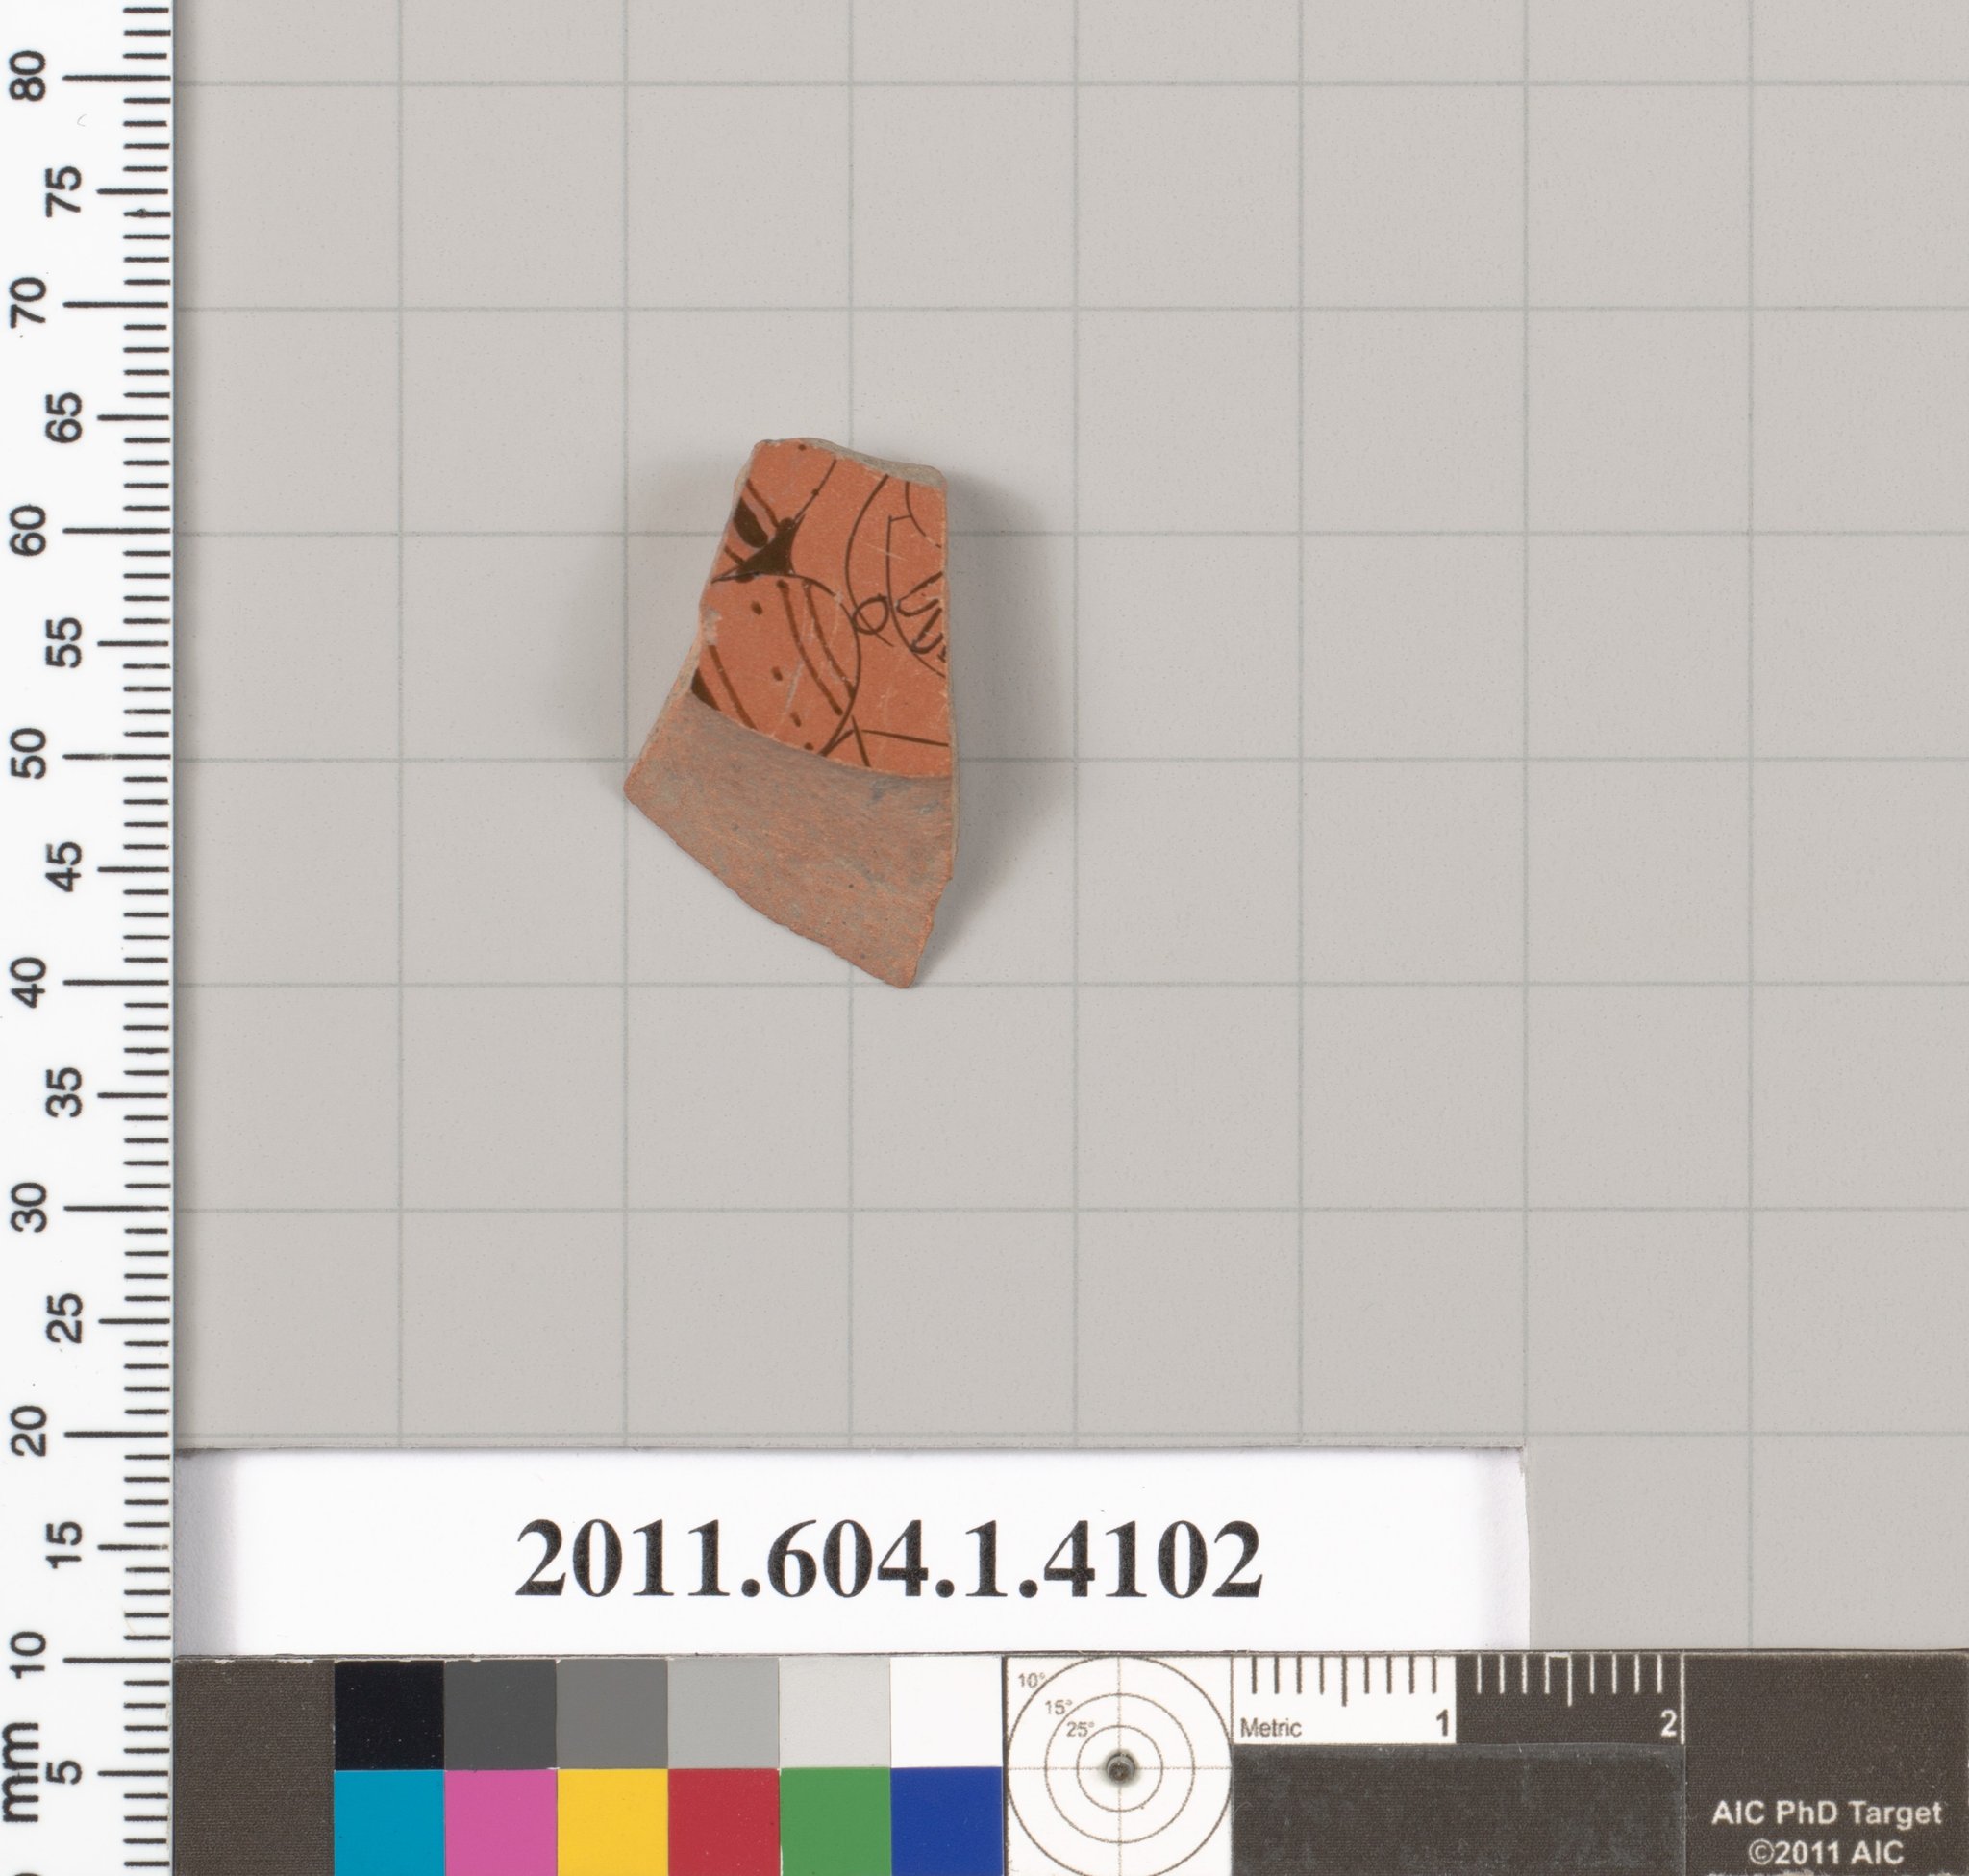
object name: kylix fragment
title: Terracotta fragment of a kylix (drinking cup)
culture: greek, attic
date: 500-480 BCE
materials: terracotta